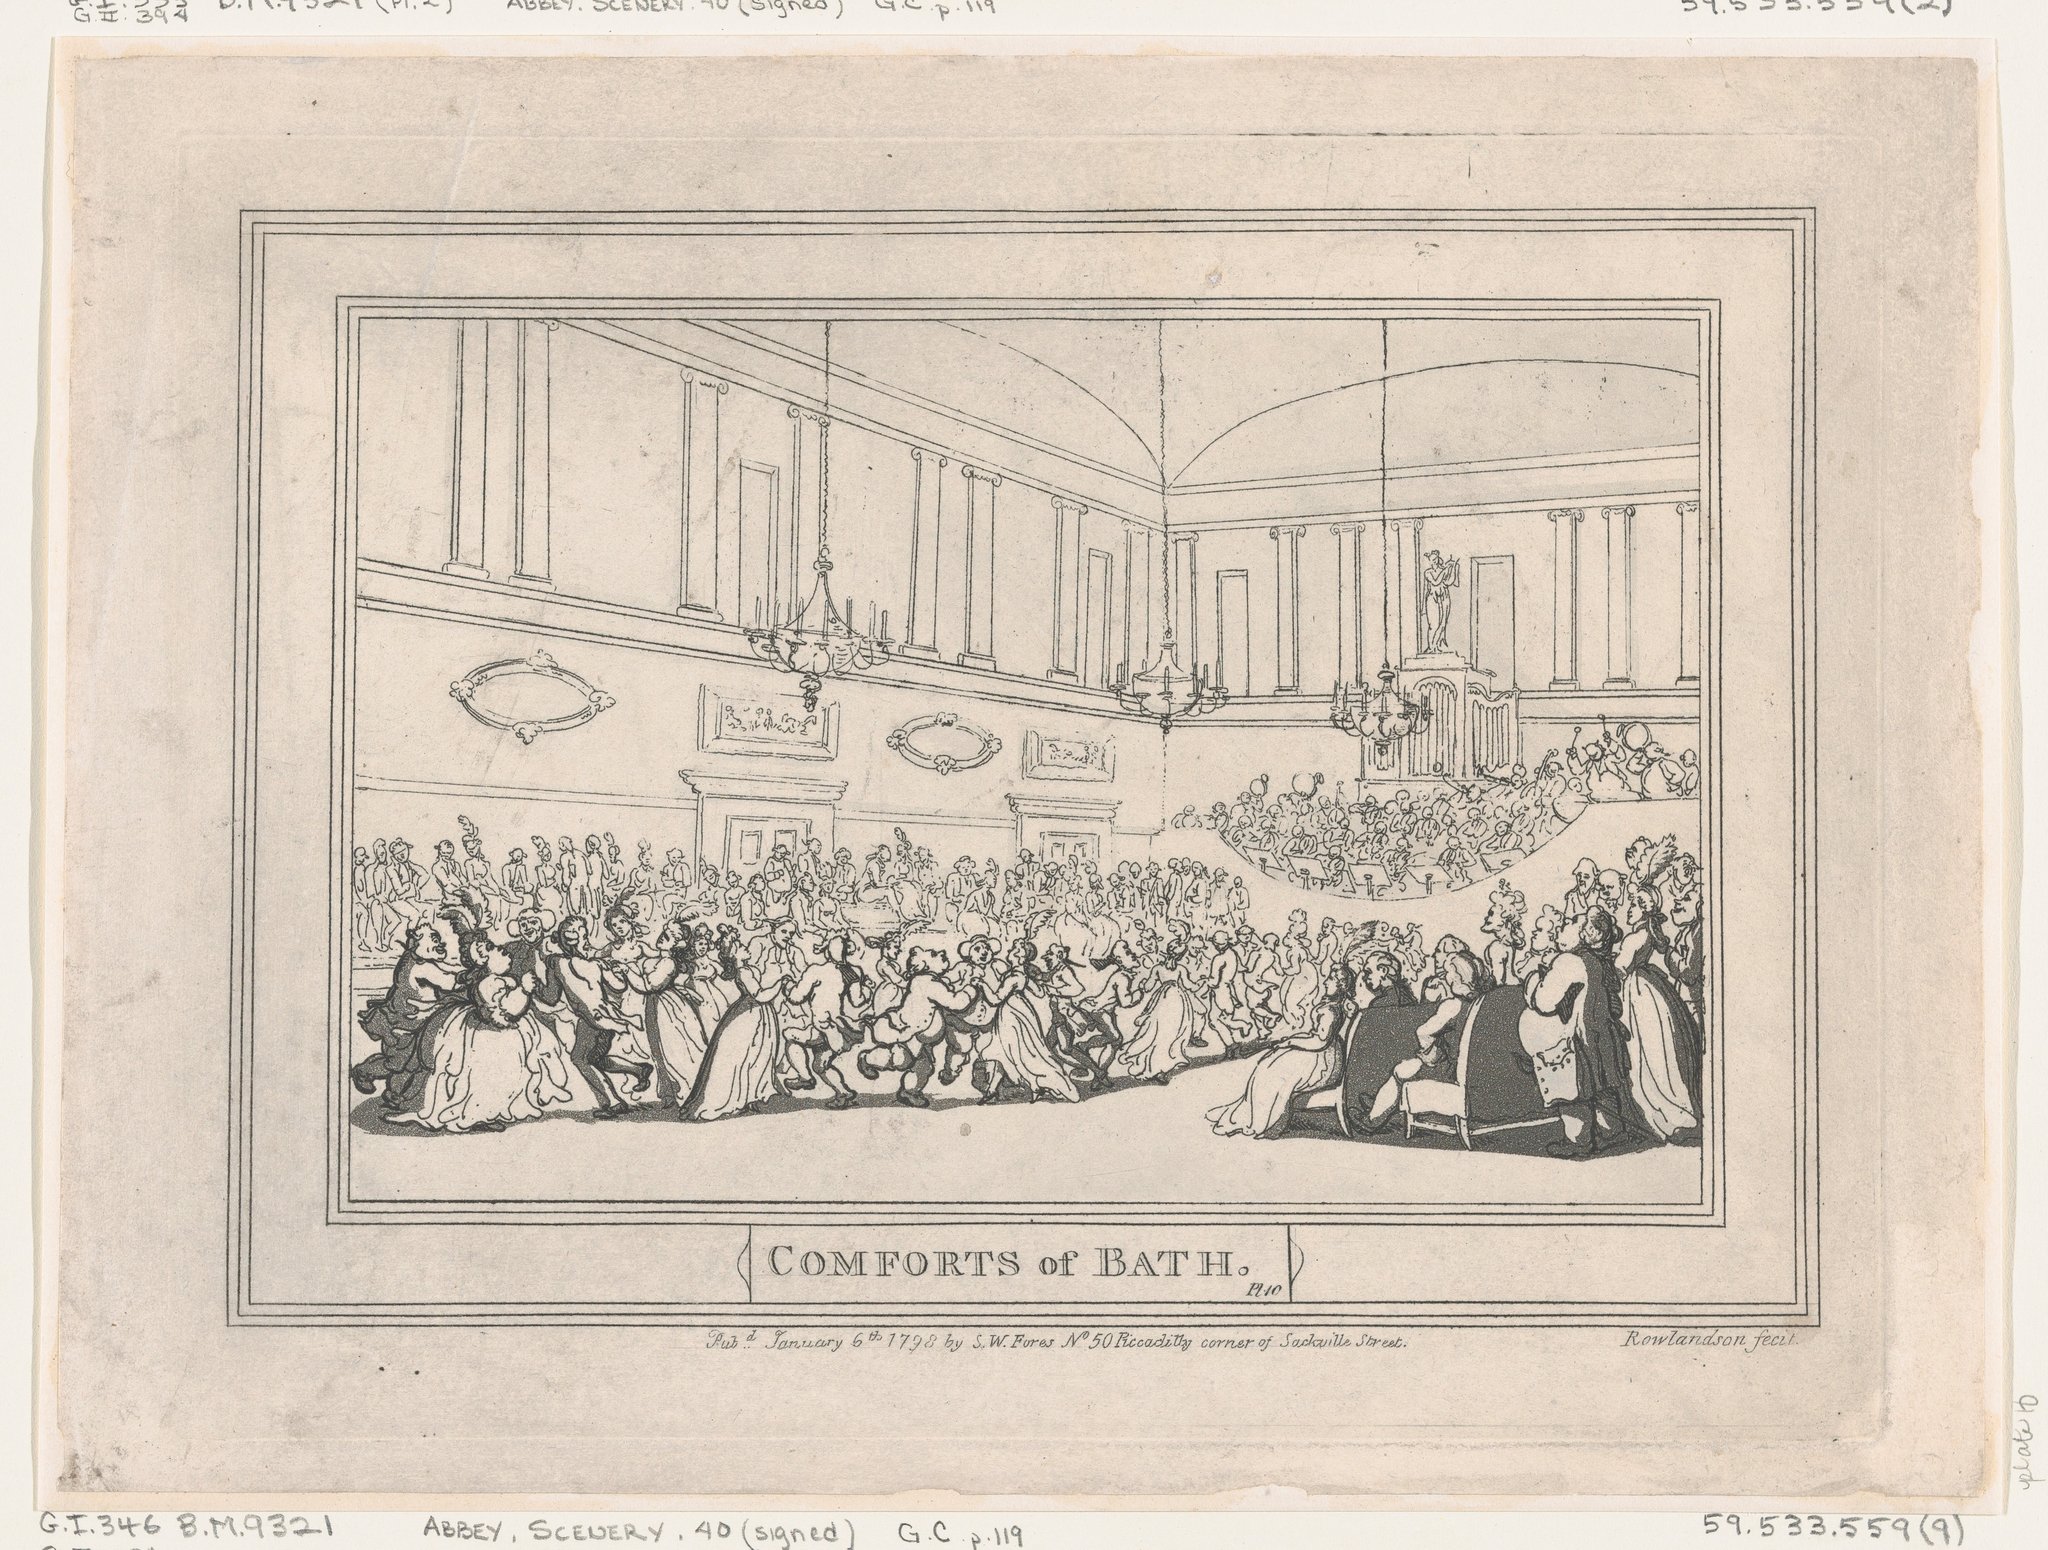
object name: print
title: Comforts of Bath, Plate 10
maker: thomas rowlandson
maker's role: artist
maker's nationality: british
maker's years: 1757-1827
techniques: etching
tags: men,women,spectators,dancing,crowd